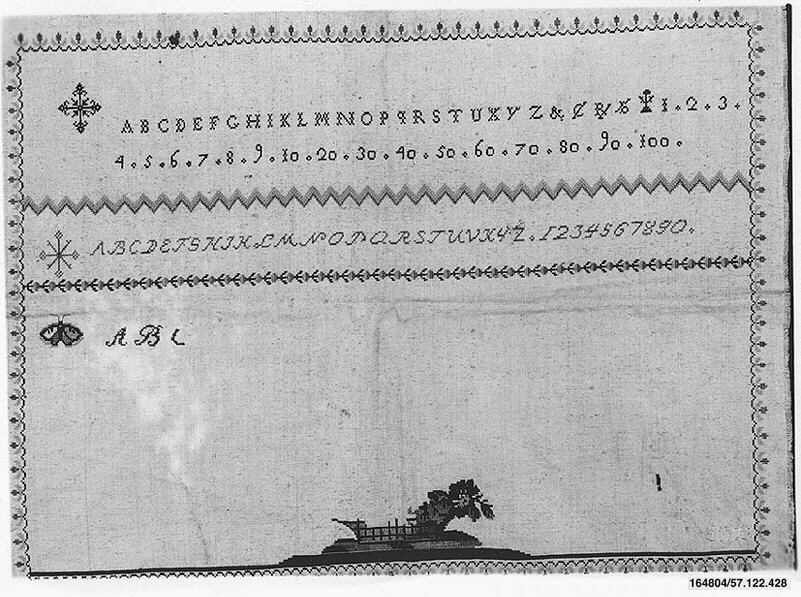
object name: sampler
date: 1801-1900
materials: linen, silk